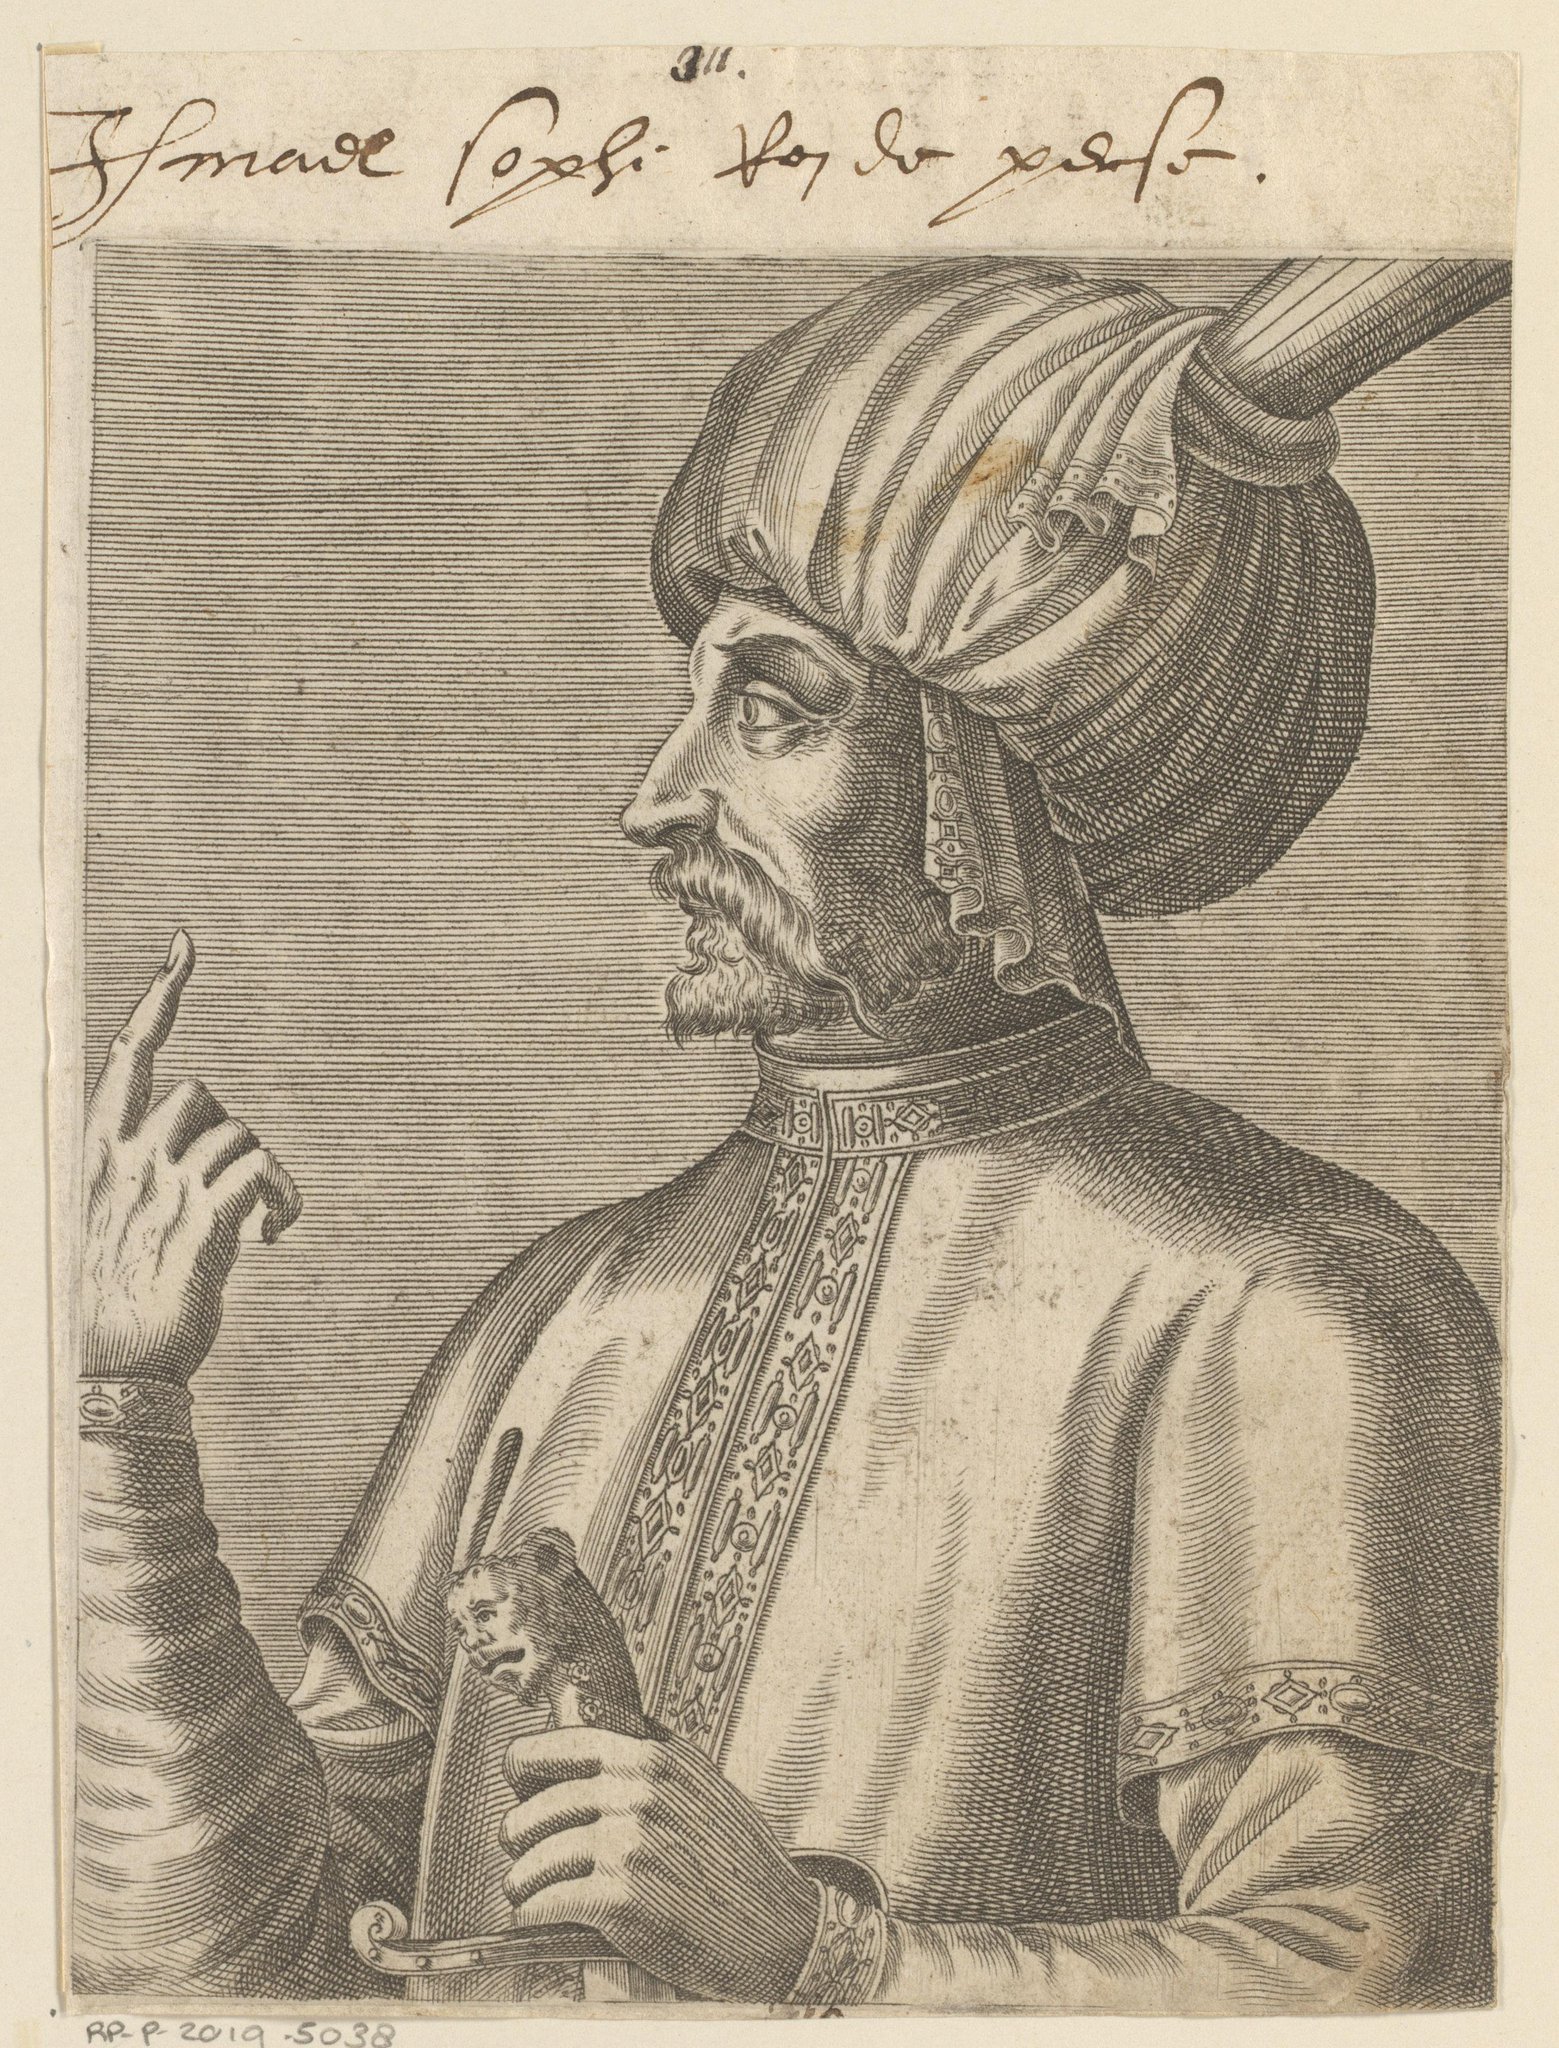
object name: print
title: Portret van Ismail I, sjah van Perzië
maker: Anonymous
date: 1584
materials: paper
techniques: engraving, etching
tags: historical persons, head-gear: turban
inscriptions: inscription: ‘Ismail [...]’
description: Prent met tekst op verso verschenen in: Thevet, André. Les vrais pourtraits et vies des hommes illustres grecz, latins et payens (...). Parijs: weduwe Jacques Kerver en Guillaume Chaudière, 1584, dl. 2, f. 657.